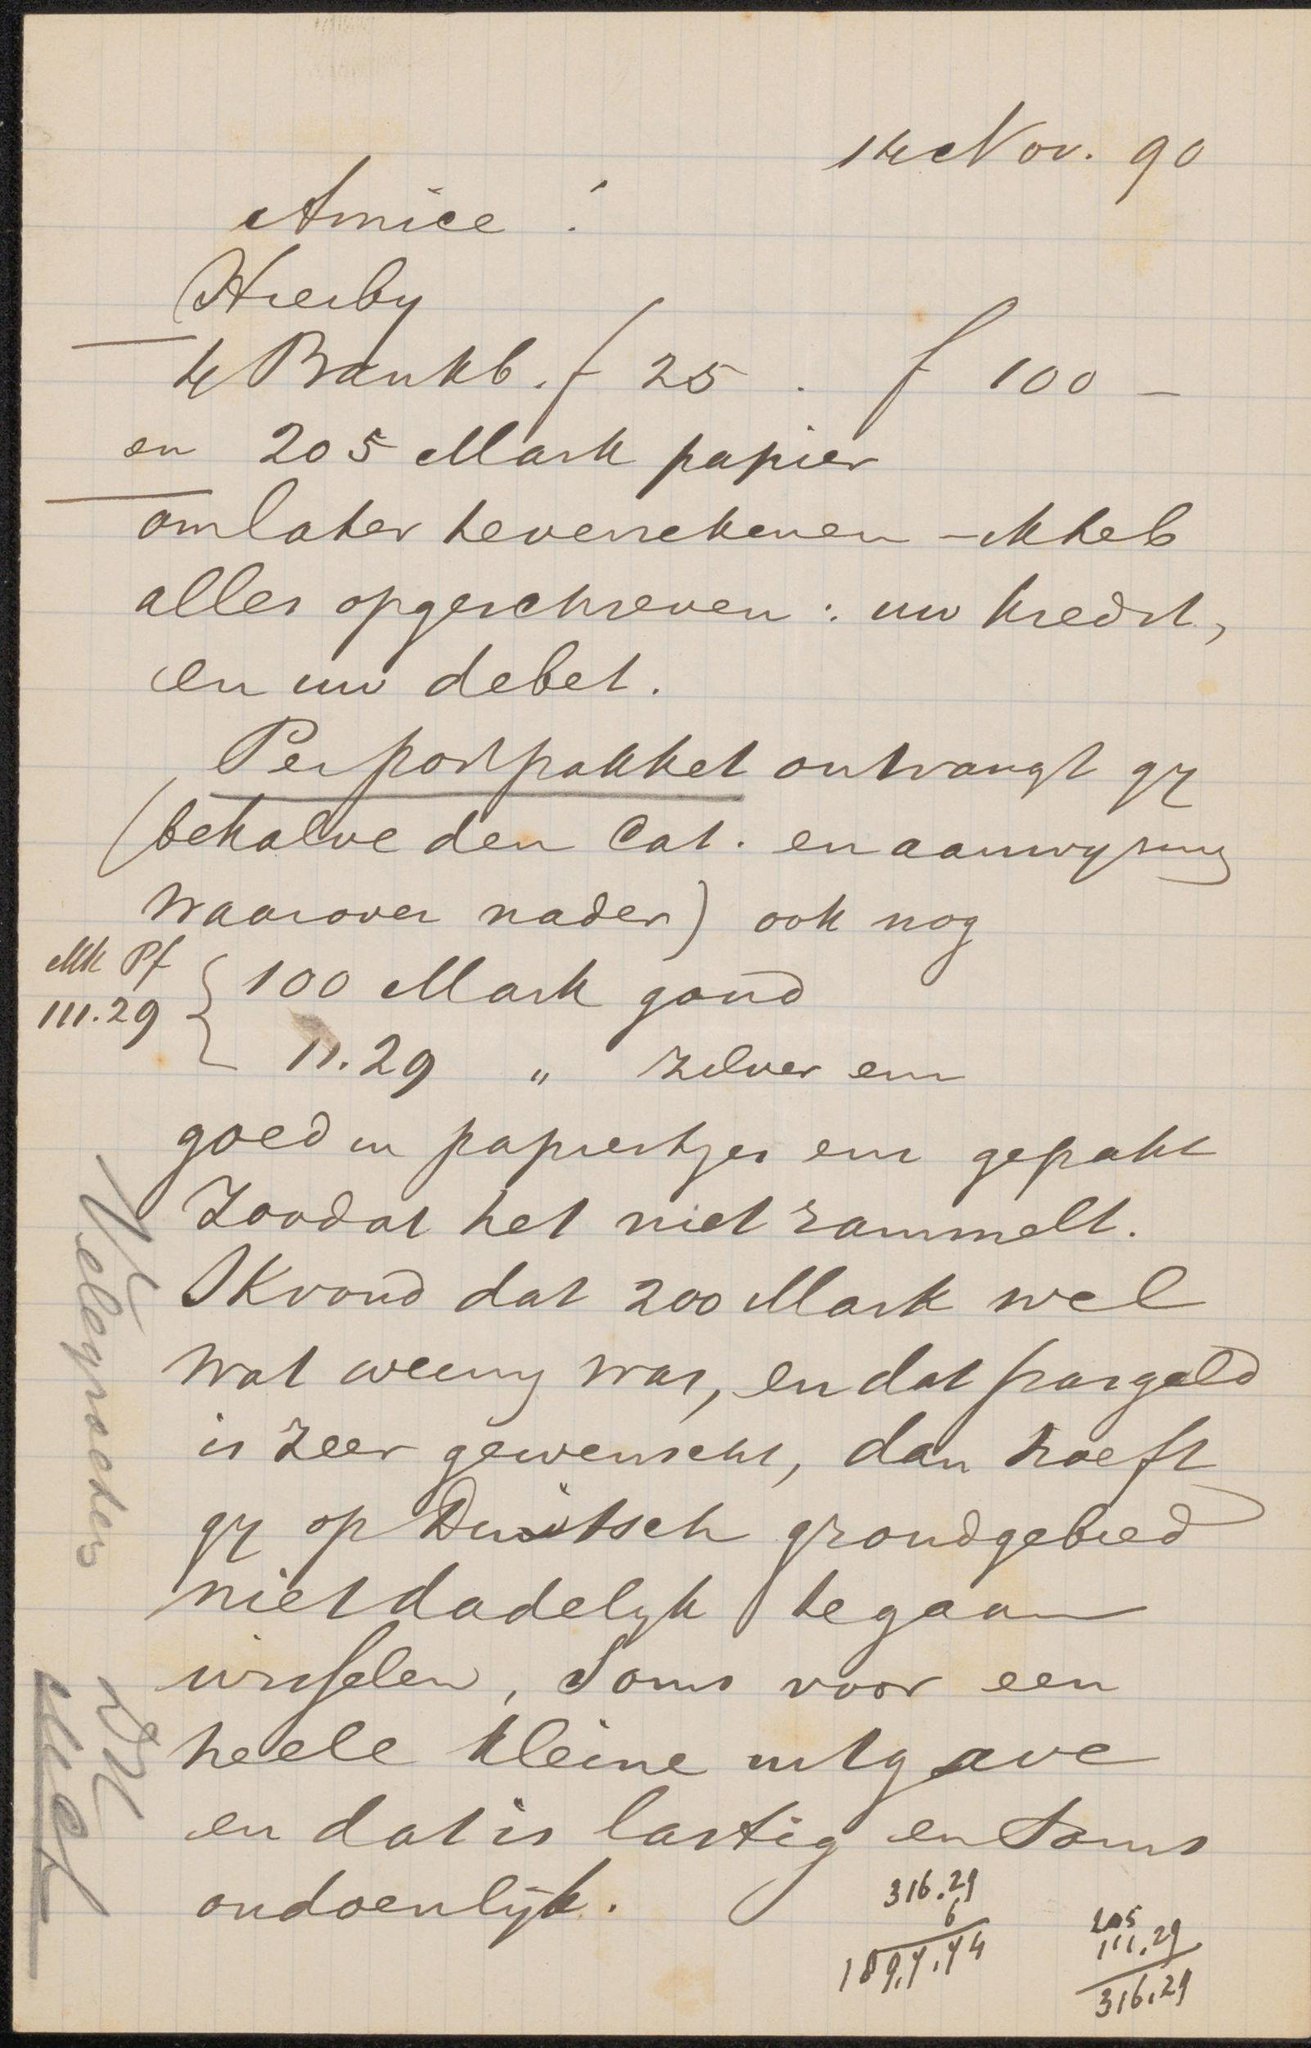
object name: letter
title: Brief aan Jan Veth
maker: martinus cornelis lebret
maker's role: verzamelaar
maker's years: 1833-1894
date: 1890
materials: ink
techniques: pen, writing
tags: designer, jan veth, leiden, amsterdam, painter, print maker, draughtsman, rembrandt van rijn, albrecht dürer, antwerp, art trade, art shop, the graphic arts, art collecting, money, berlin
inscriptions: collector's mark: ‘RPK’